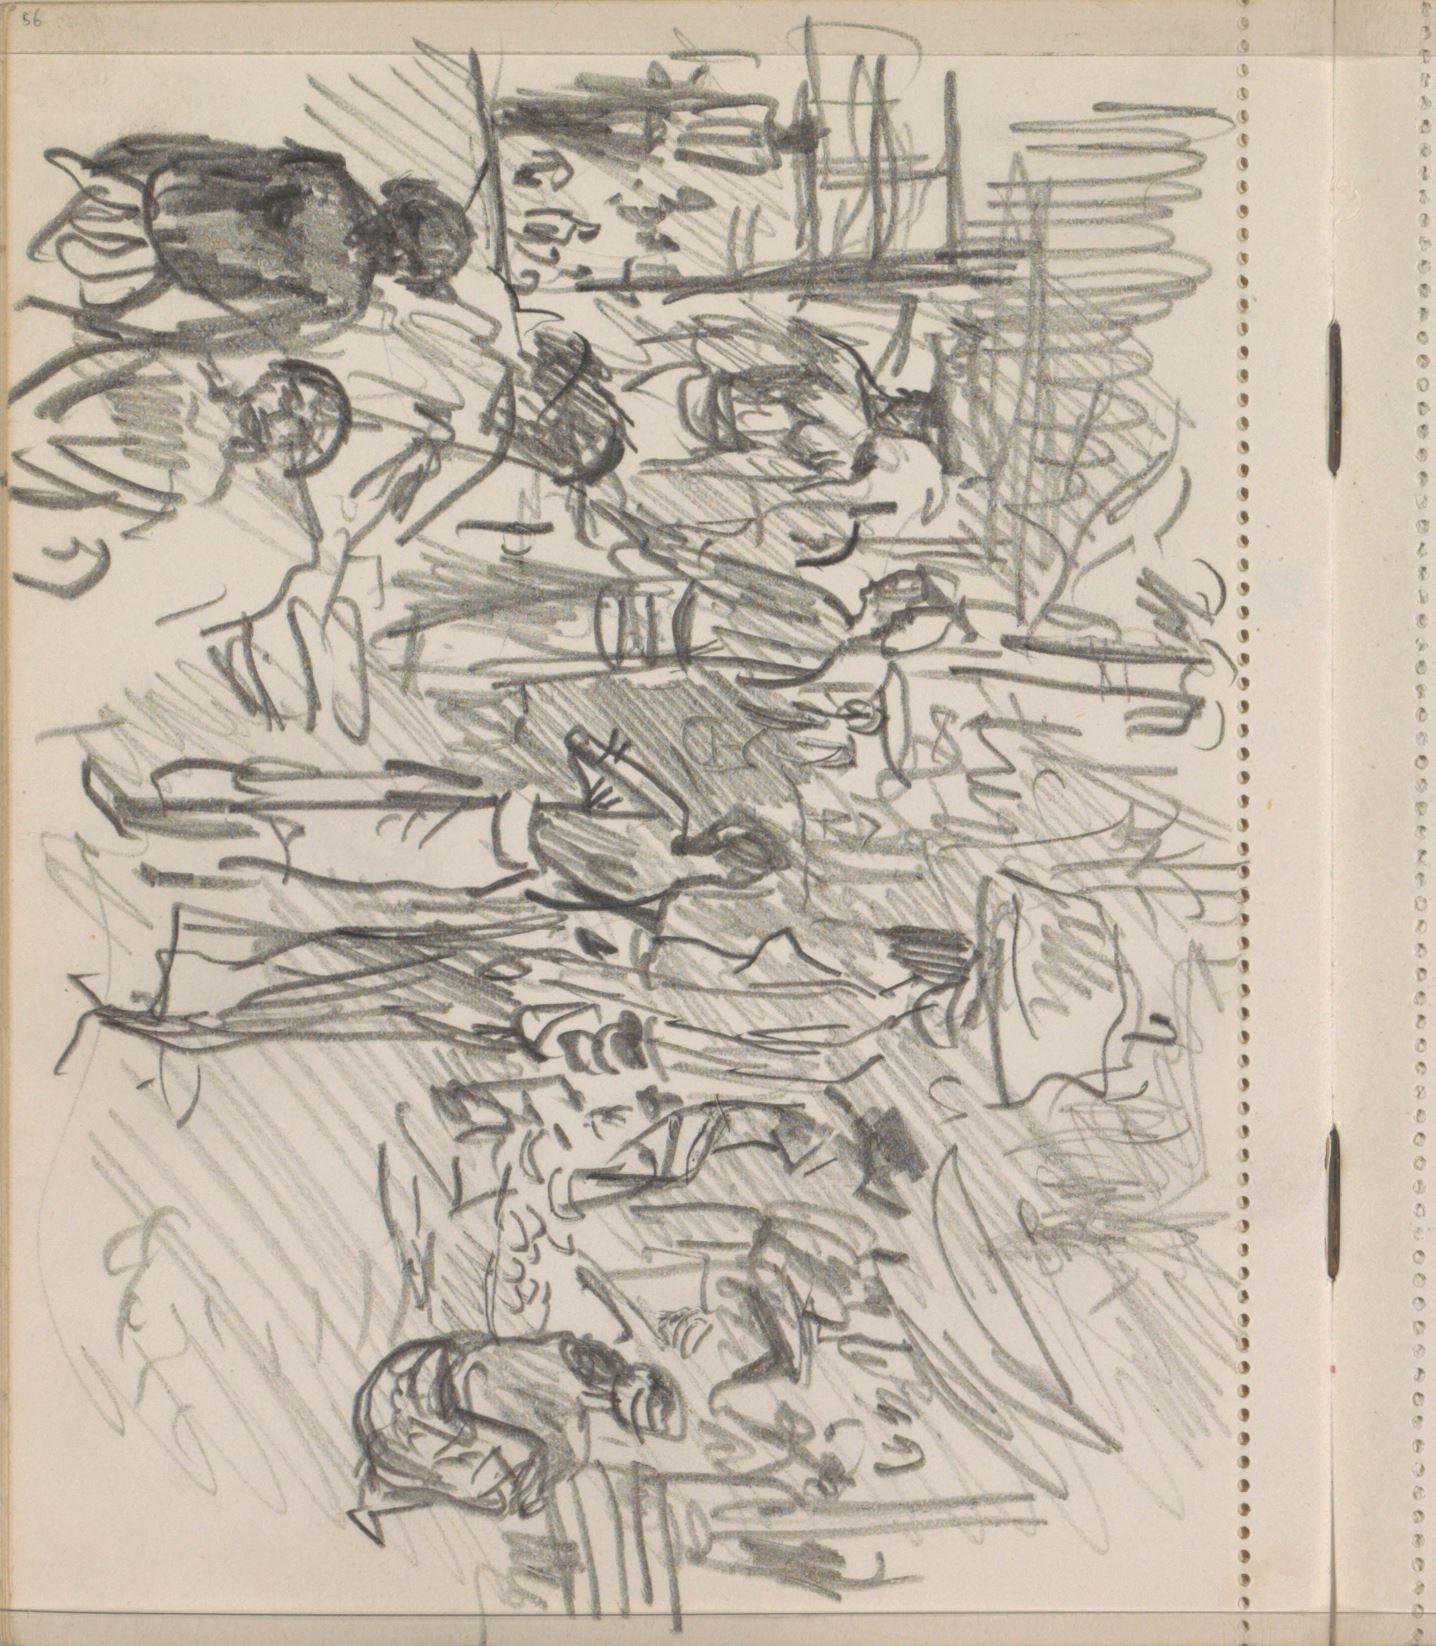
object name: sketchbook leaf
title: Straat met figuren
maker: marius bauer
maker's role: draughtsman, print maker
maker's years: 1867-1932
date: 1925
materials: paper, pencil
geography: indonesia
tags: asiatic races and peoples, street (+ city(-scape) with figures, staffage)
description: Pagina 56 uit een schetsboek met 67 bladen.